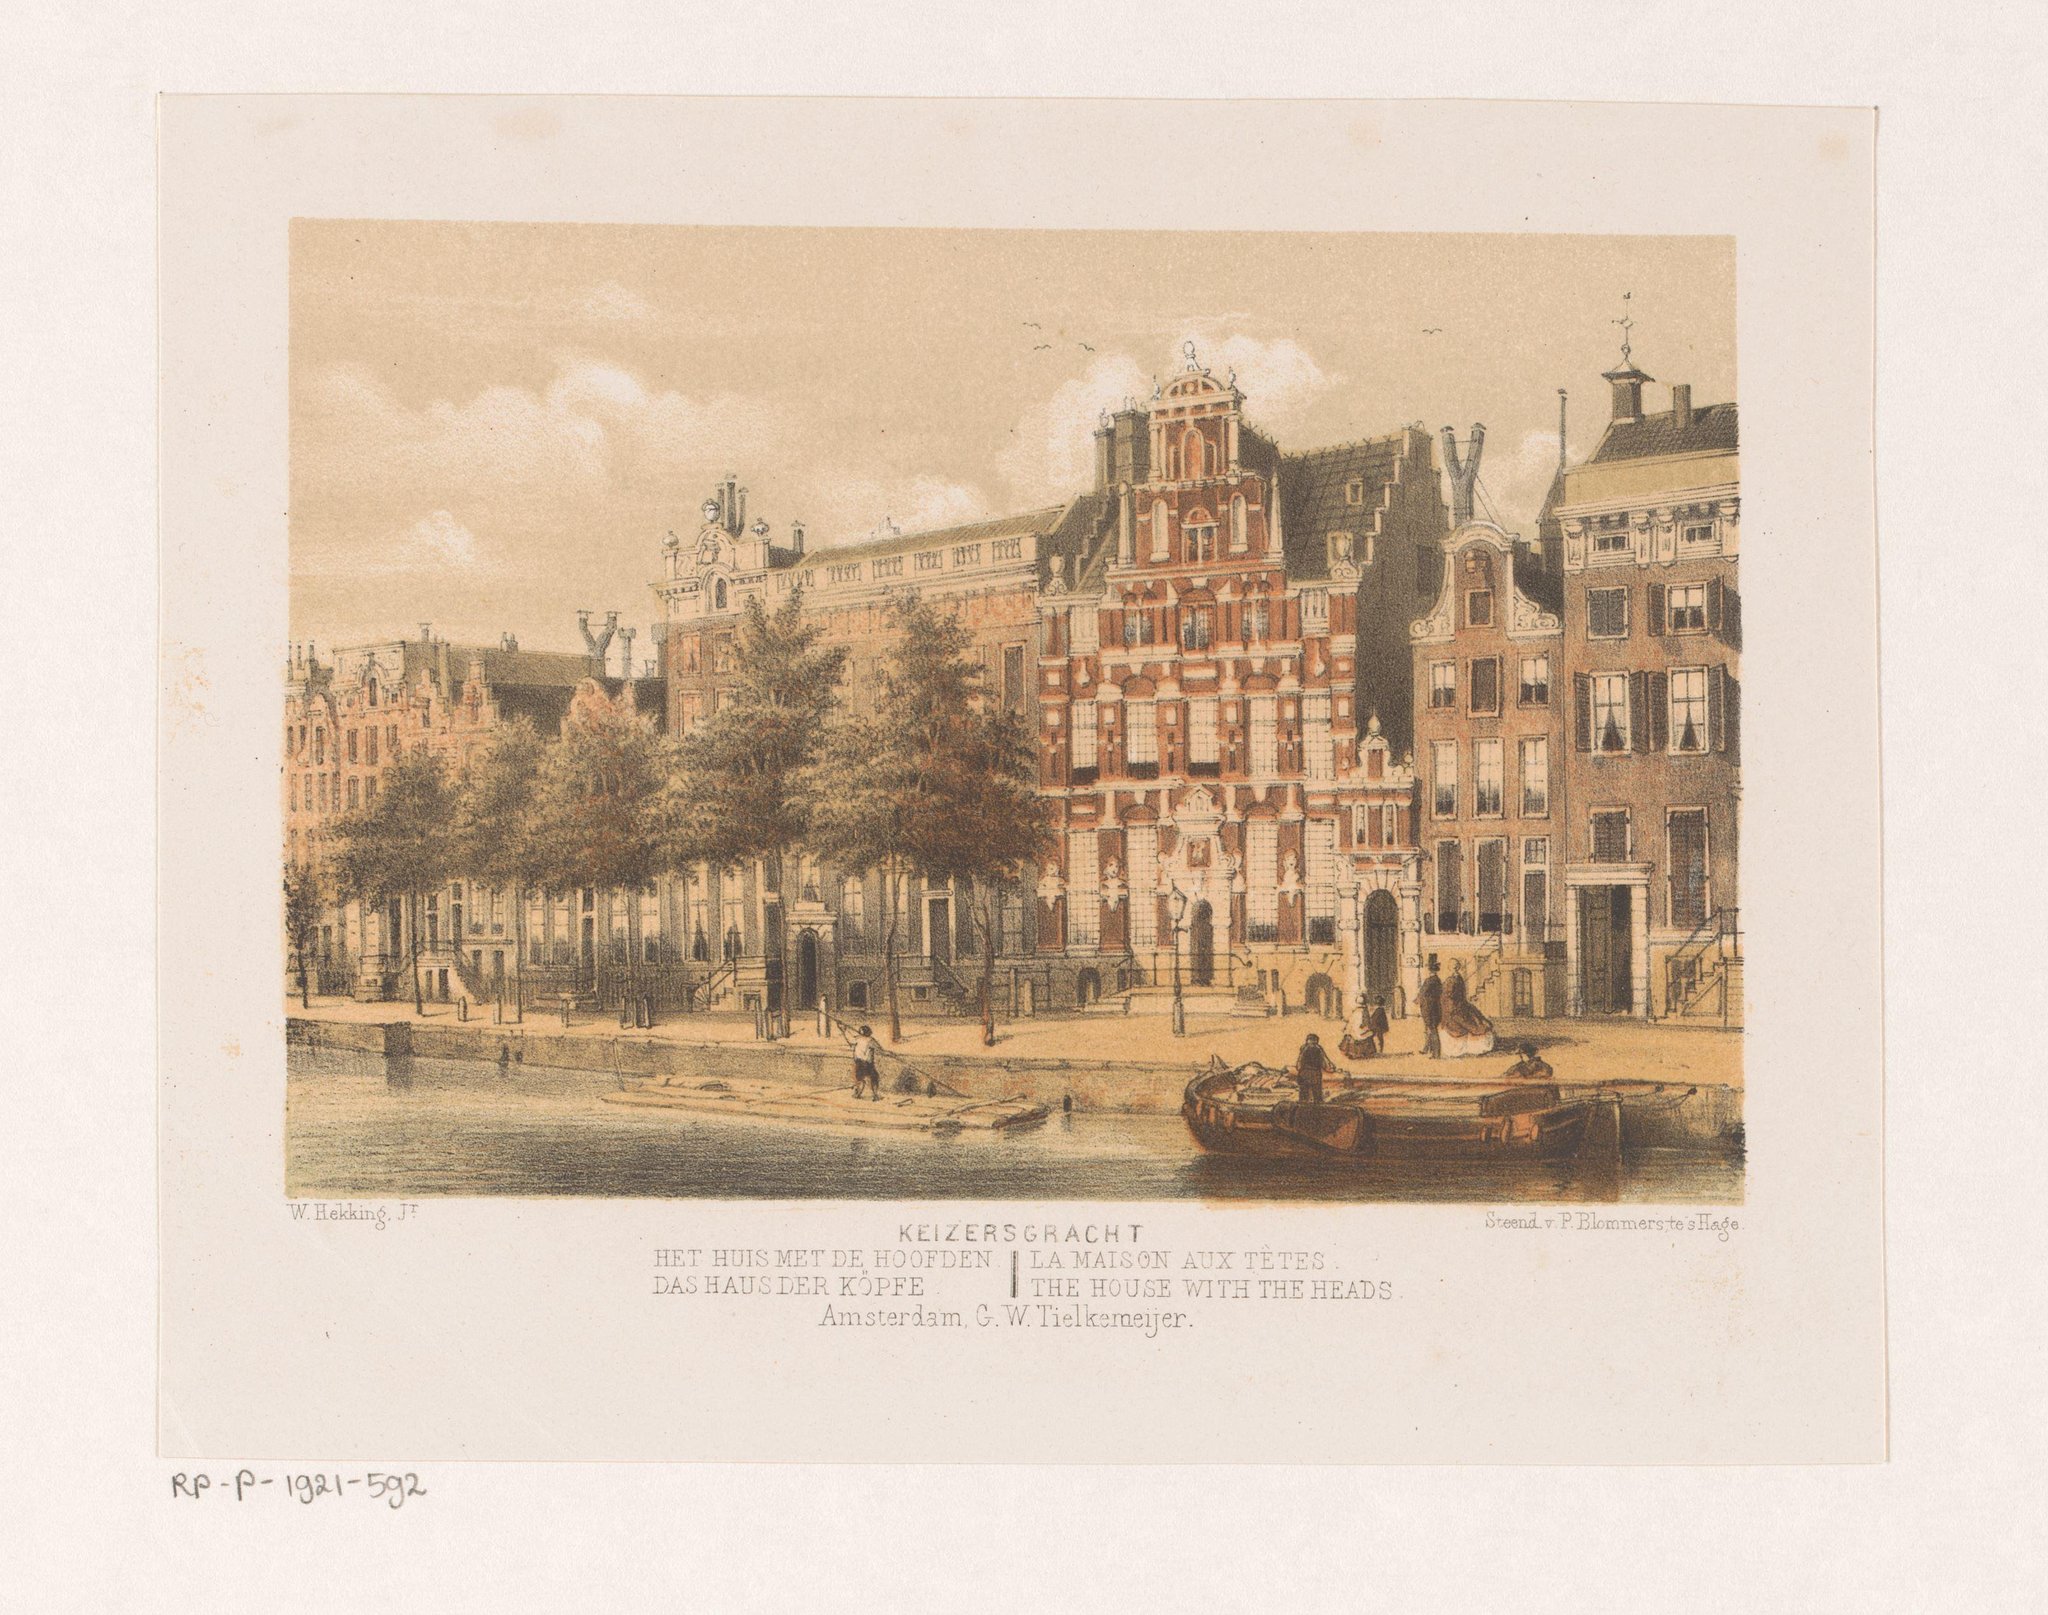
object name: print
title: Huis met de Hoofden aan de Keizersgracht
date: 1843-1887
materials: paper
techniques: tone lithography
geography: amsterdam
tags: canals, waters (in city)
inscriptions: collector's mark: Lugt 2233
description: Op de gracht lopen figuren, op het water liggen een vlot en een boot.